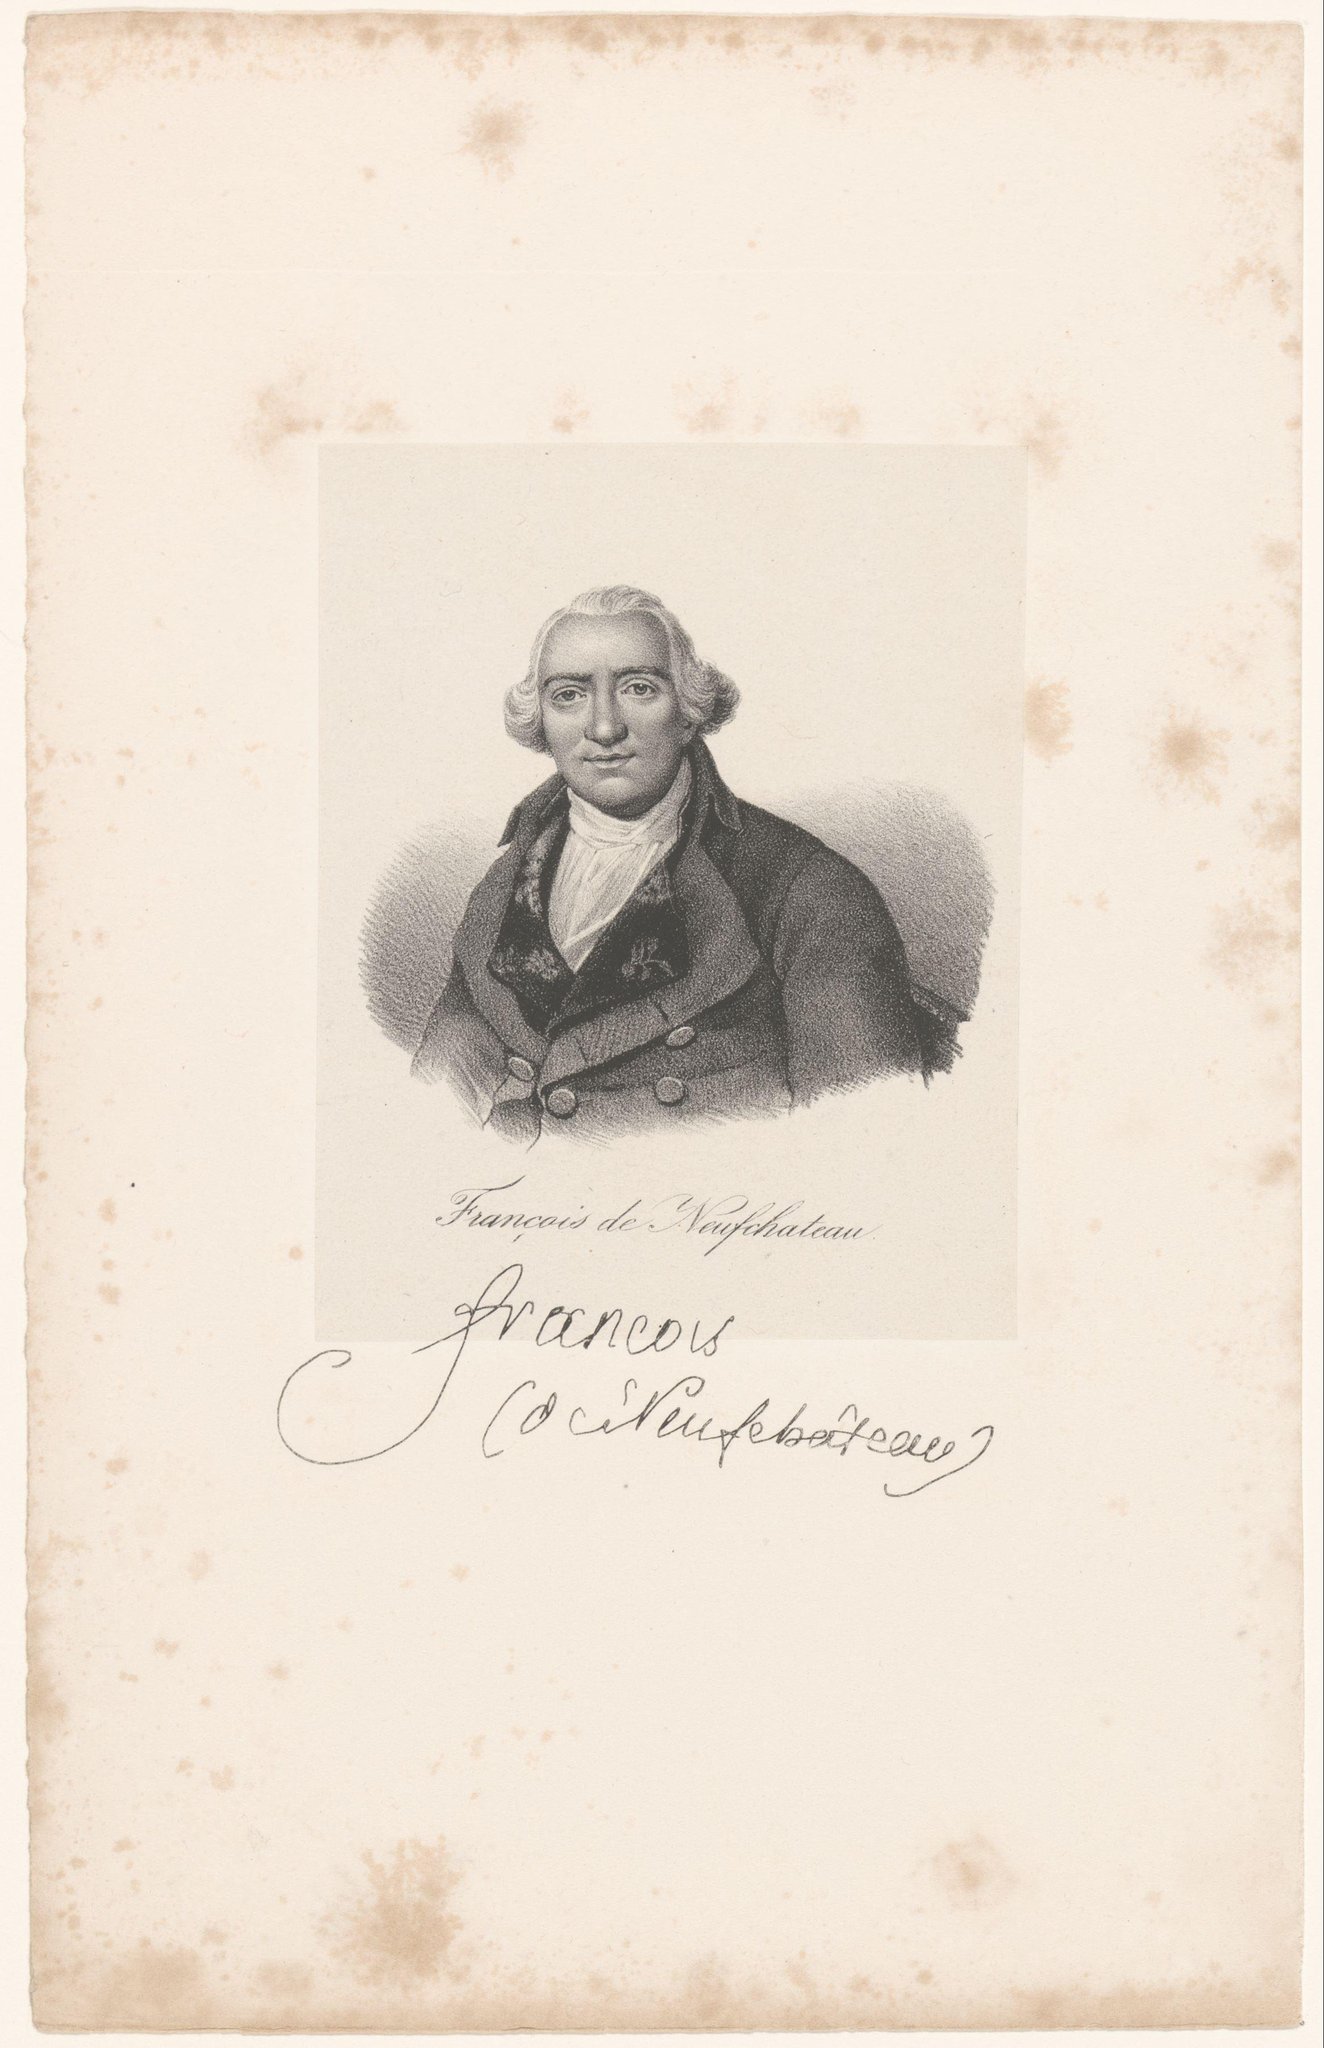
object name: print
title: François de Neufchateau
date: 1828-1842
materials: paper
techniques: lithograph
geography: paris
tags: paris, historical persons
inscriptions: collector's mark: Lugt 2228a